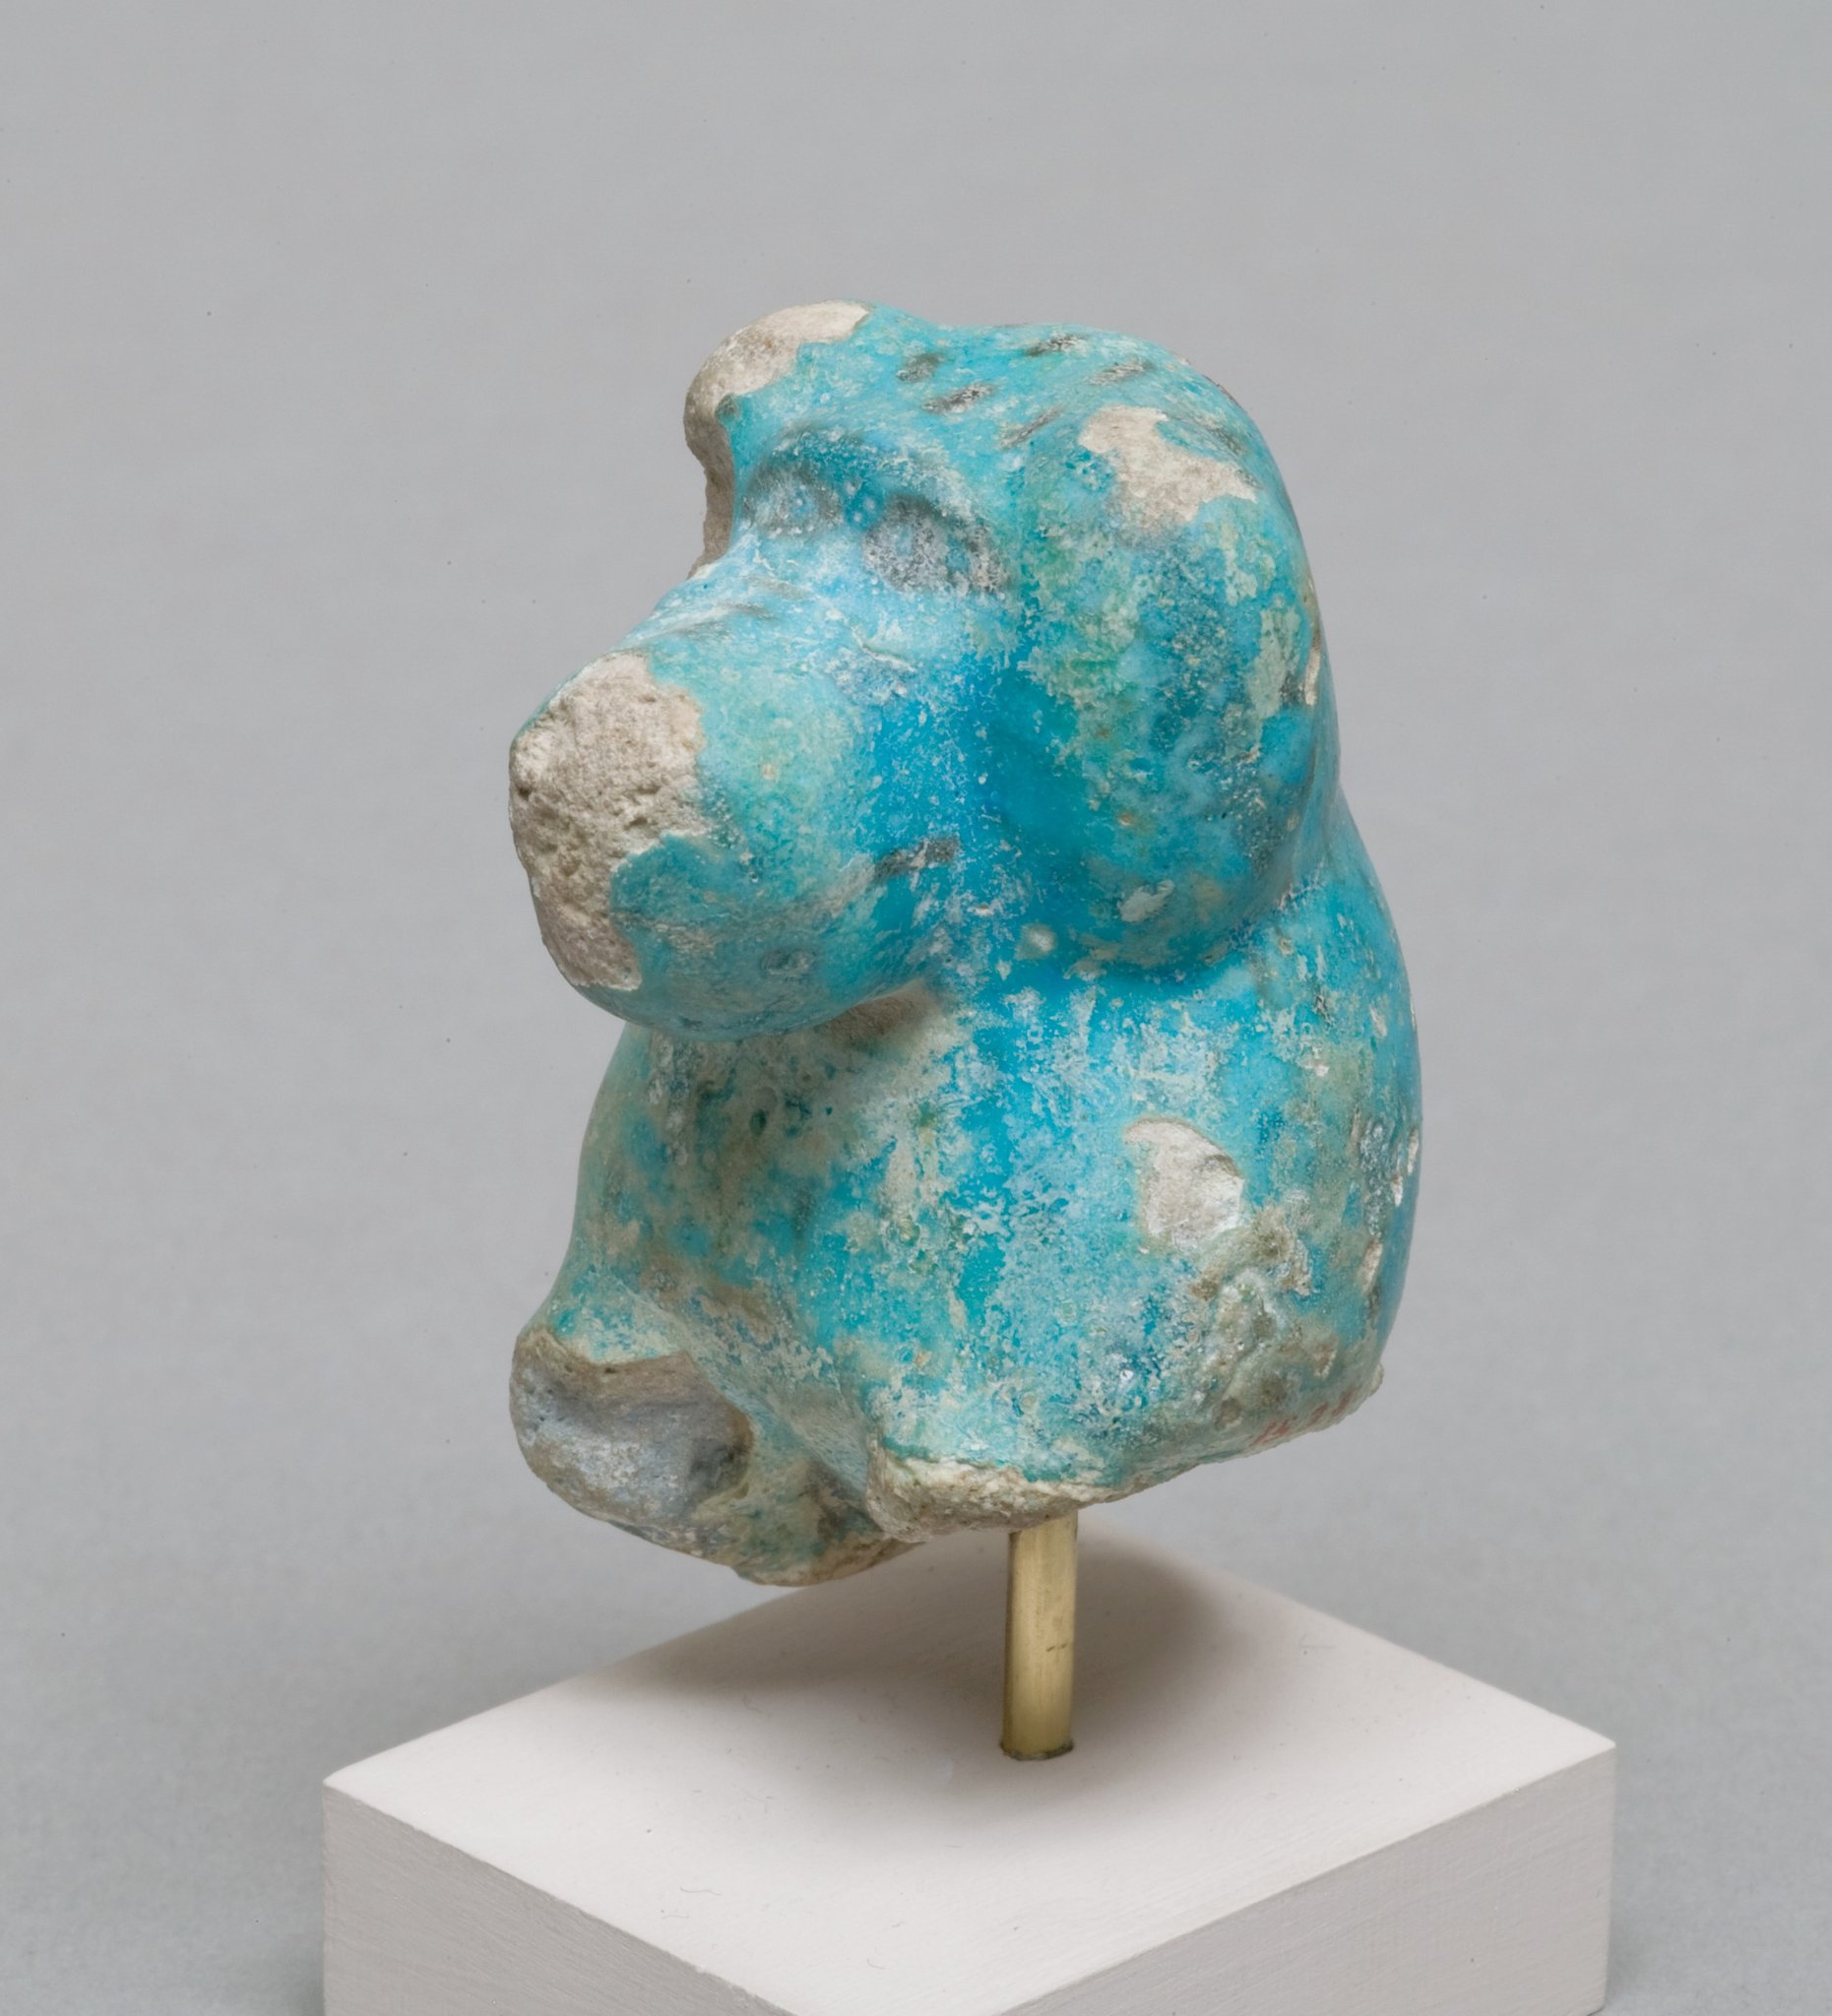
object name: figurine, baboon, upper half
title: Upper part of a baboon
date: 1950-1900 BCE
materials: faience, paste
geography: egypt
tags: baboons